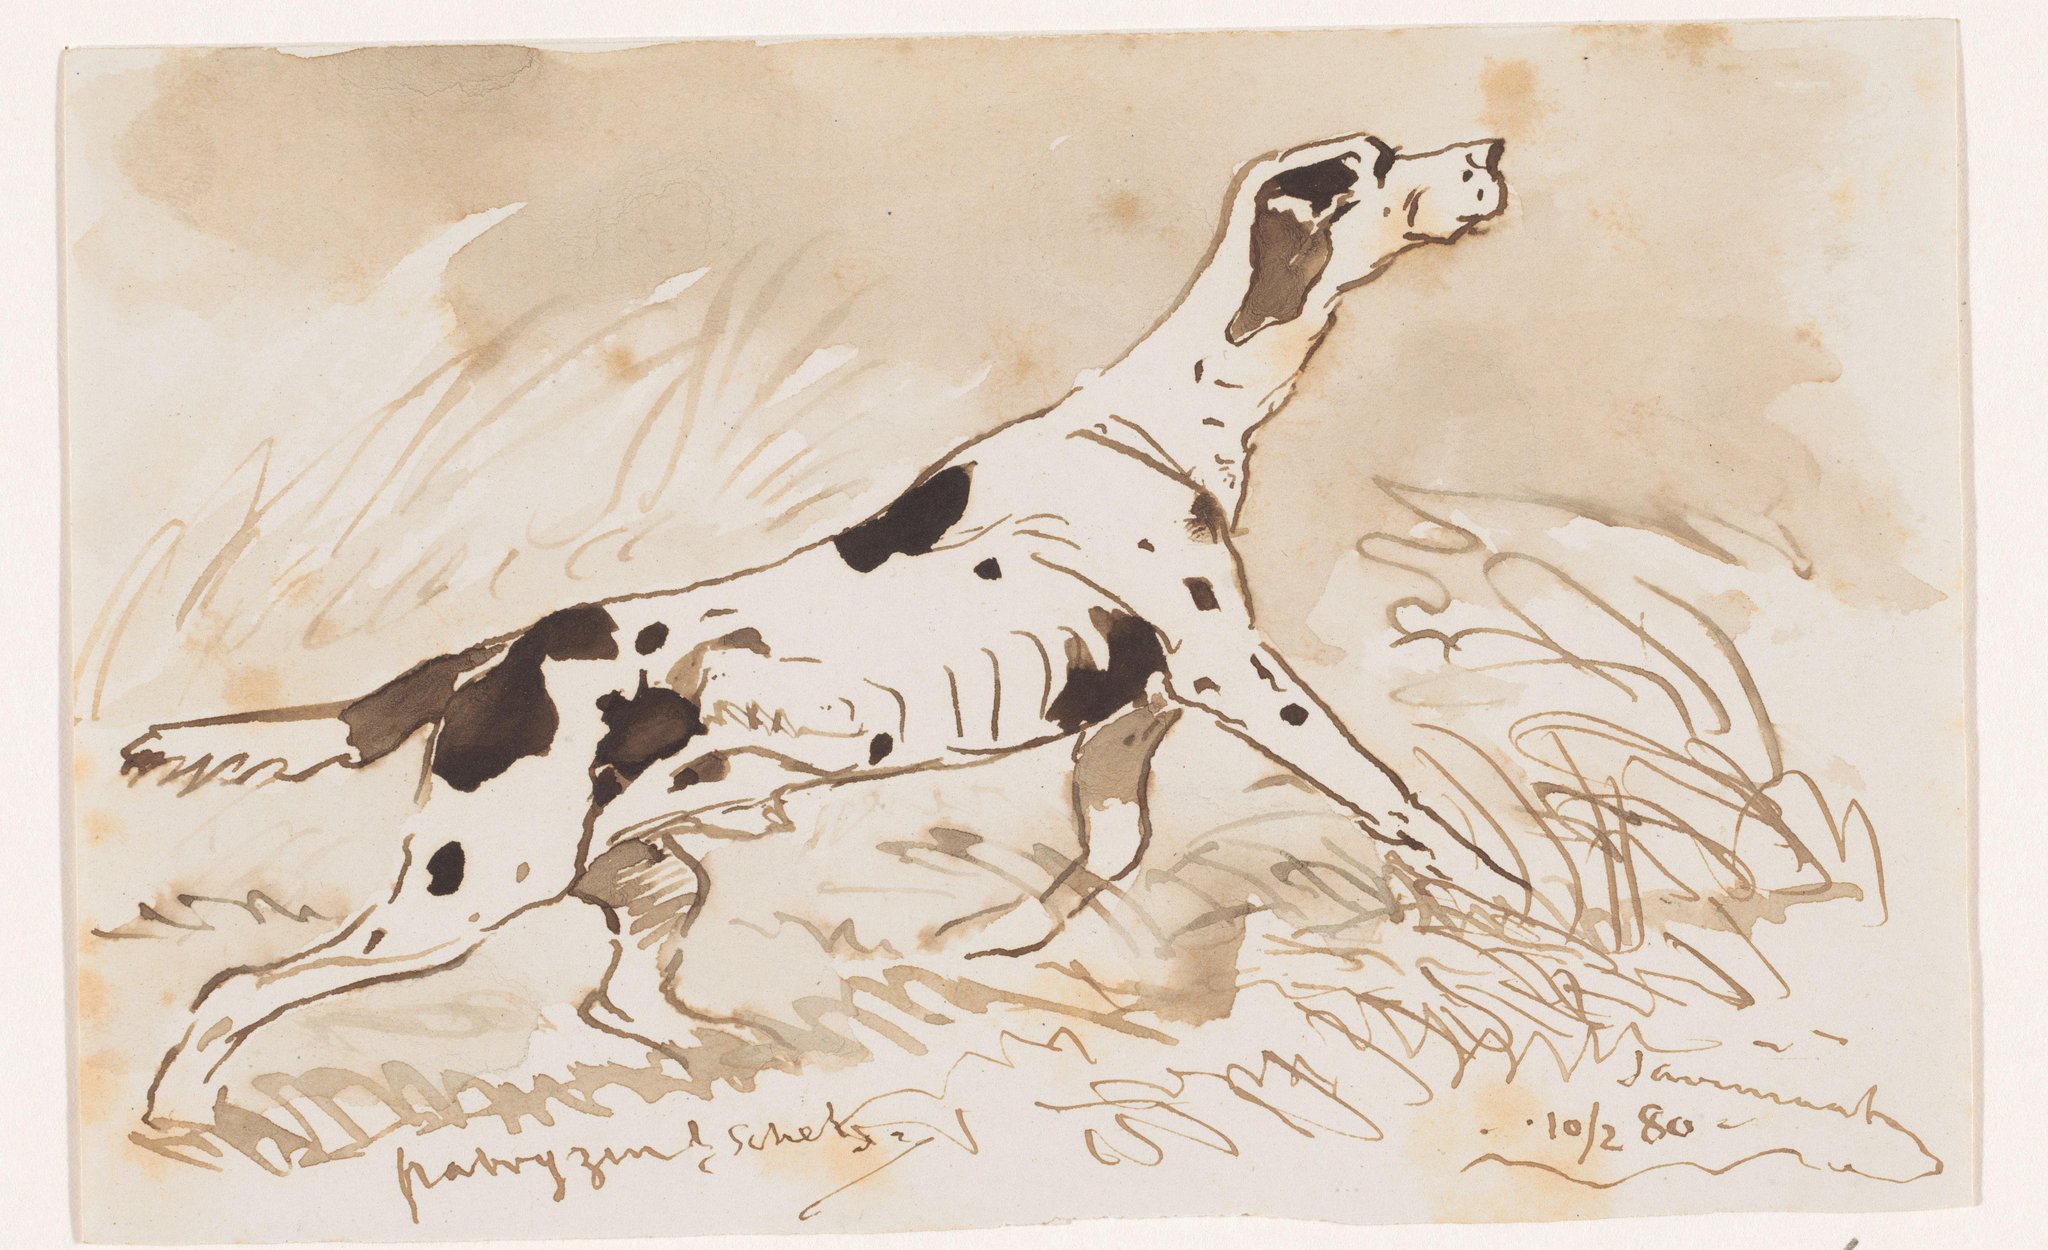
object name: drawing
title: Patrijzen!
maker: johannes tavenraat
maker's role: draughtsman, painter, print maker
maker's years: 1809-1881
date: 1880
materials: ink, paper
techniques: brush, pen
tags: hunting dogs, dog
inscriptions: collector's mark: Lugt 2228, annotation: ‘Patrijzen! Schets.’, signature and date: ‘Tavenraat 10/2 80.’